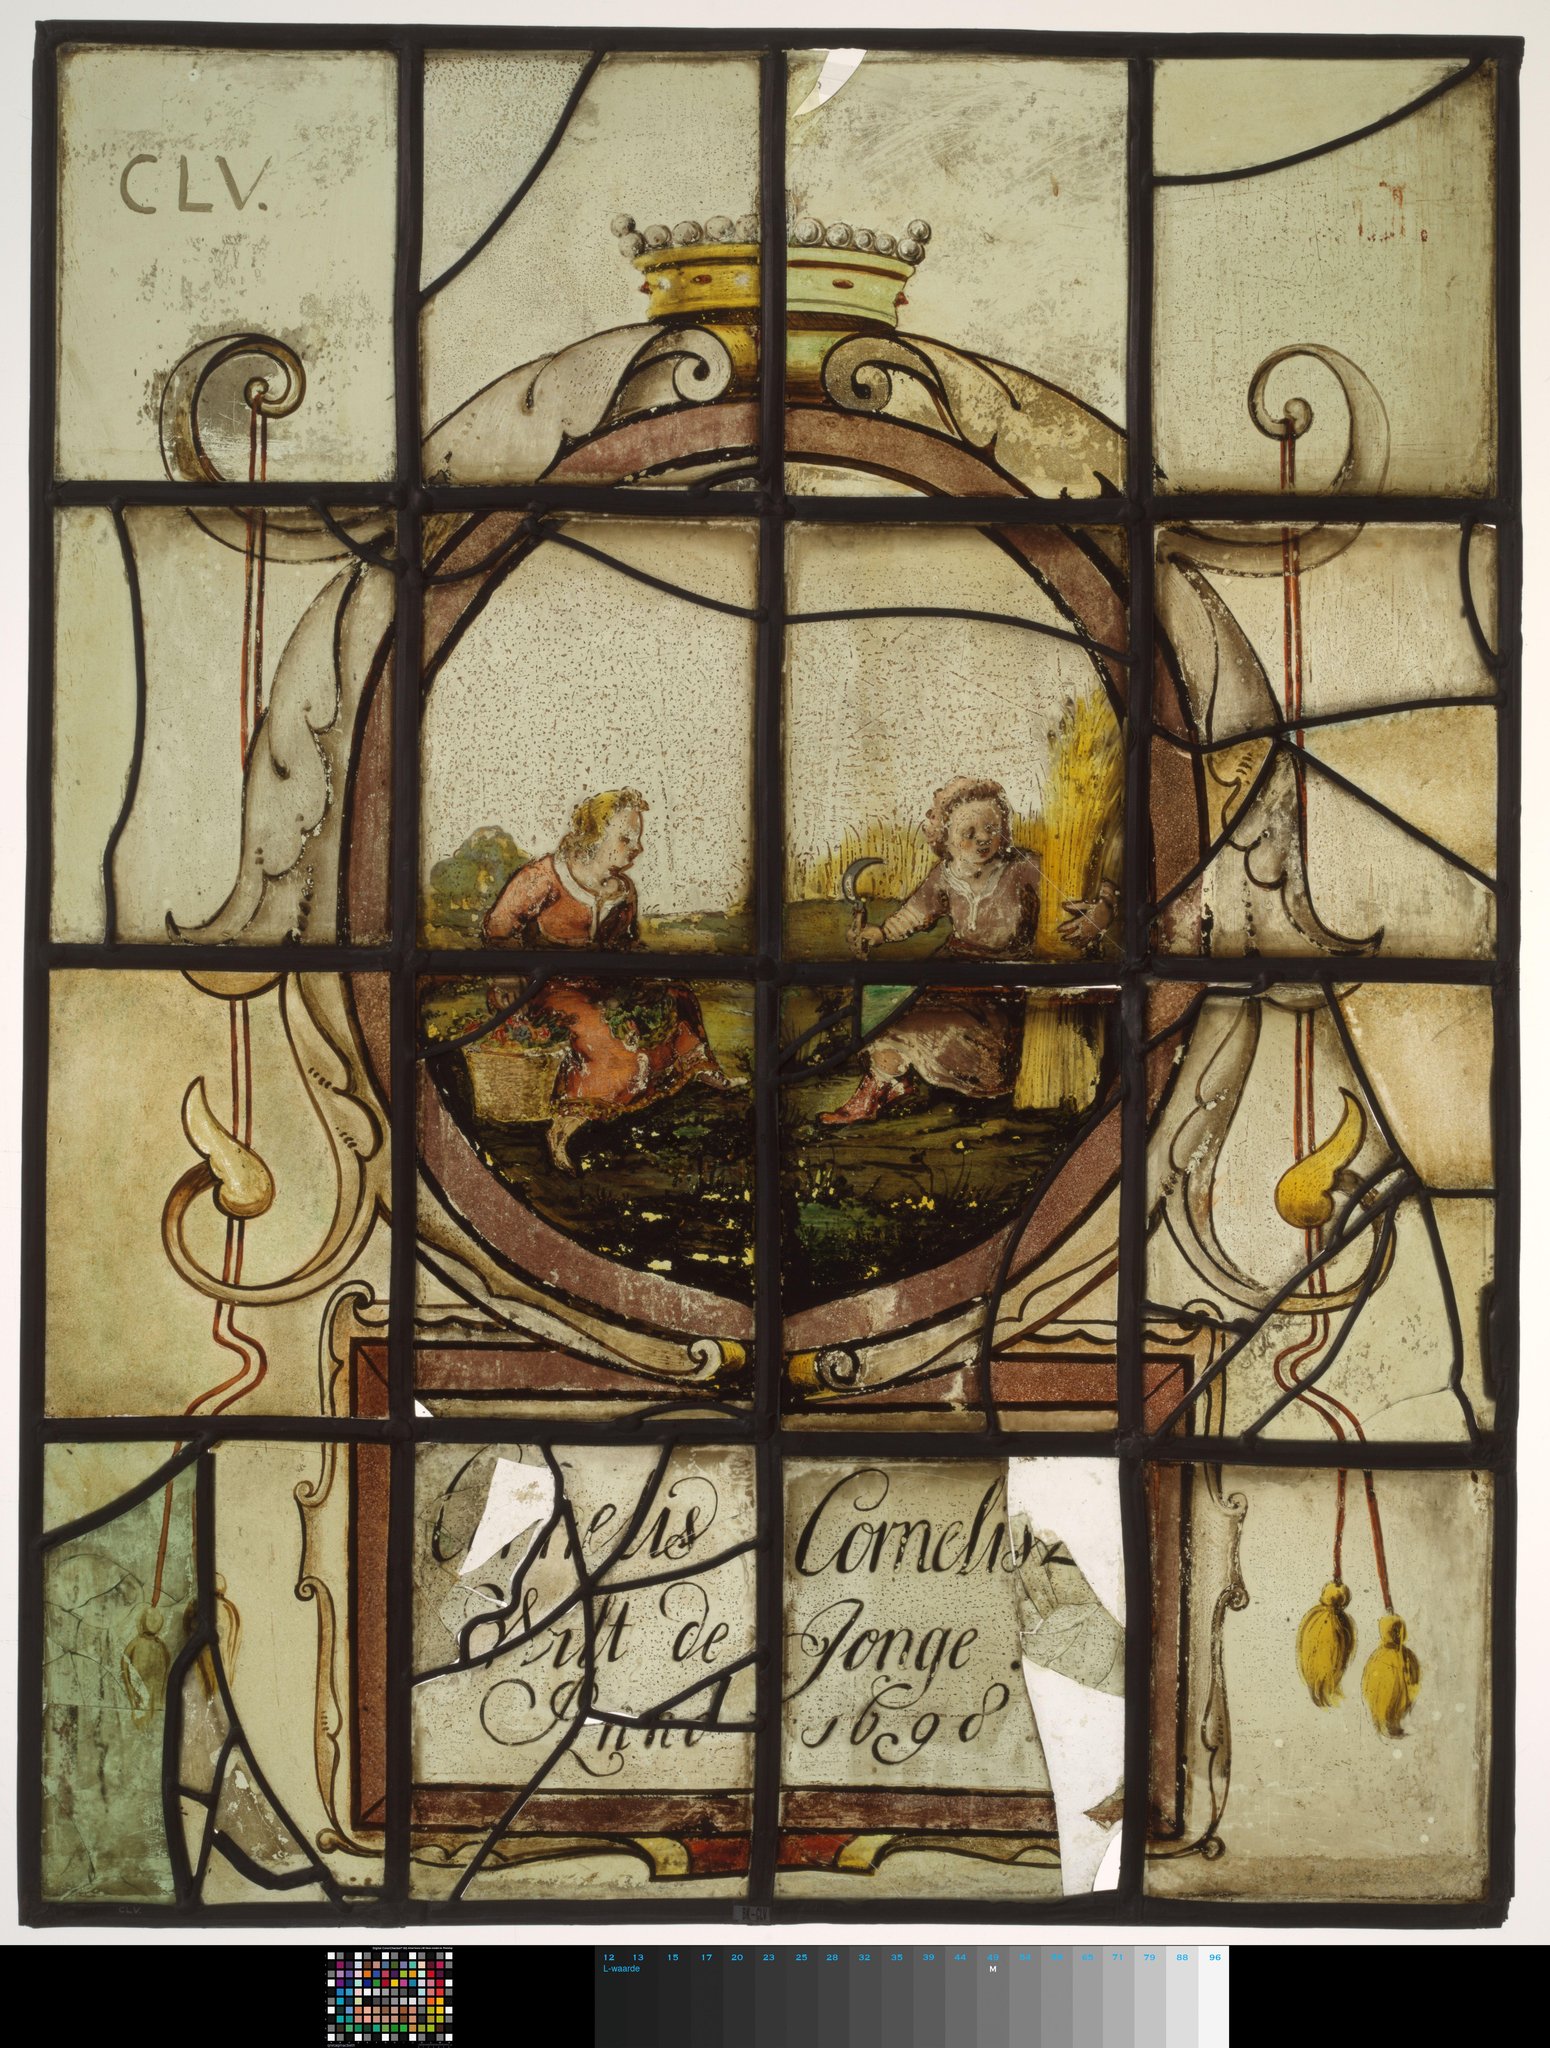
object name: light window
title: Ruit met twee vrouwen in een korenveld en onderschrift "Cornelis Cornelisz Wilt de Jonge Anno 1698"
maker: Anonymous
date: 1698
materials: glass, lead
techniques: leading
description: Ruit met twee vrouwen in een korenveld en onderschrift "Cornelis Cornelisz Wilt de Jonge Anno 1698".